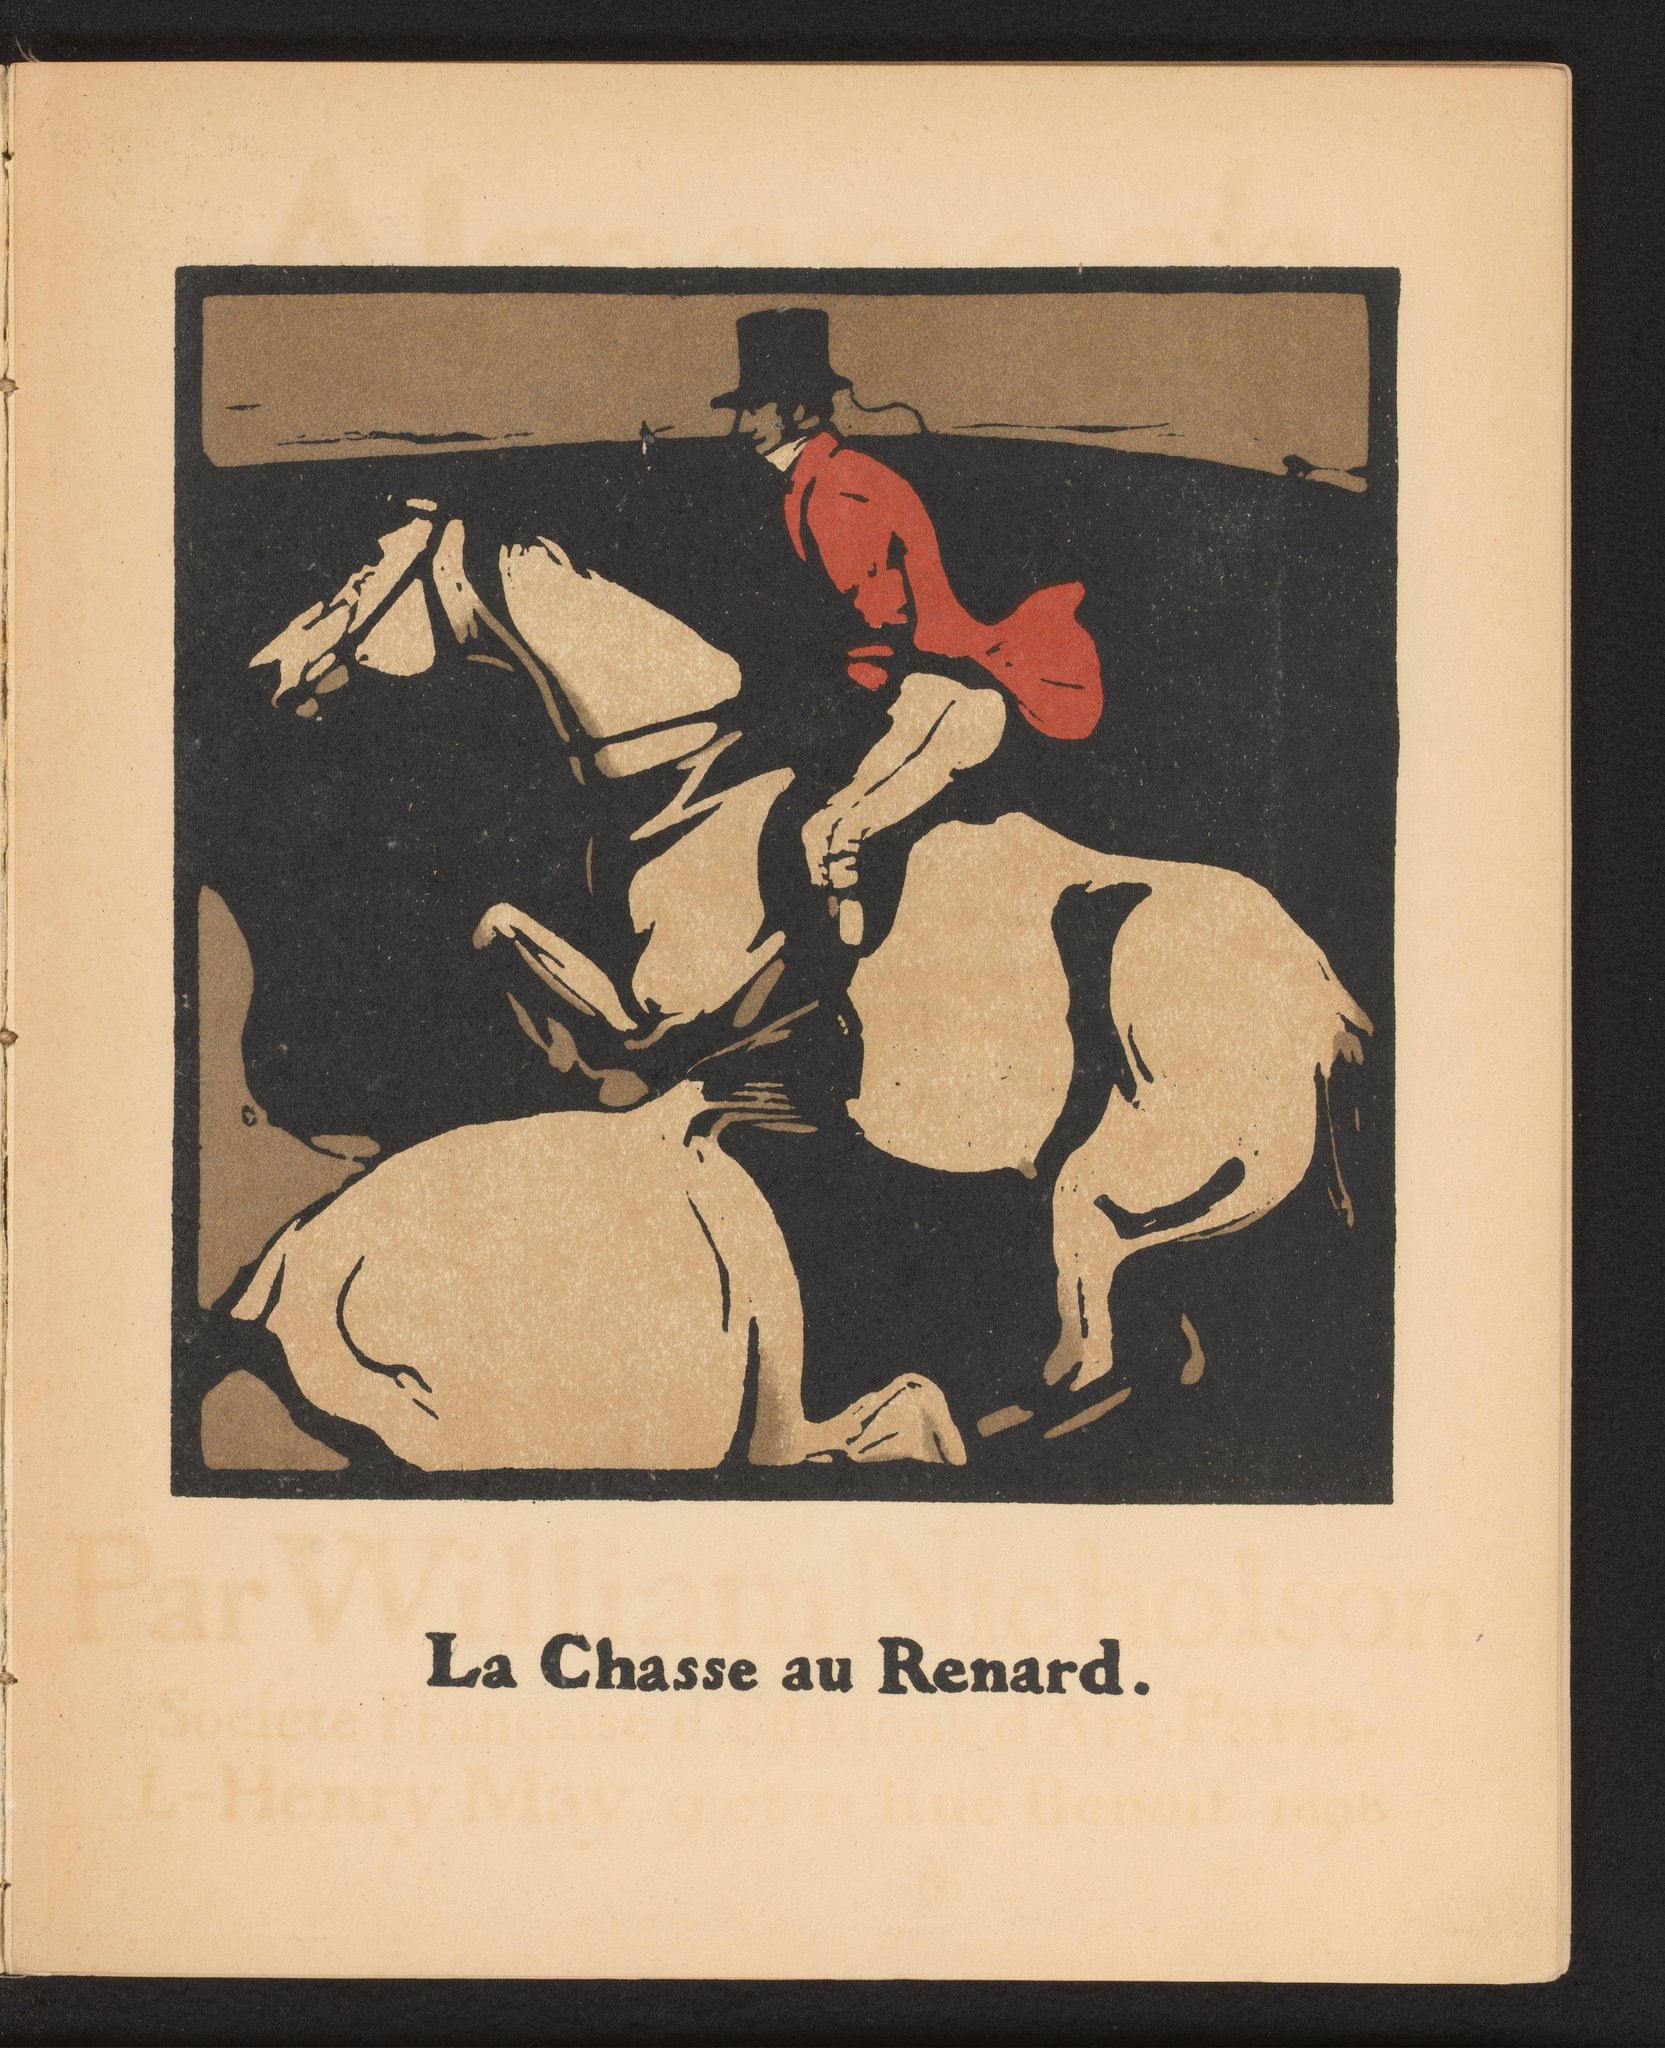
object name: print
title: Almanak met twaalf sporten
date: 1898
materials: paper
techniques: lithograph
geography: paris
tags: calendar, almanac, jockey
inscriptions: : ‘Fevrier./ Dimanche - 6 13 20 27/ Lundi - 7 14 21 (...)’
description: Prent maakt deel uit van een boek. Illustratie bij kalendermaand op tegenoverliggende blad.